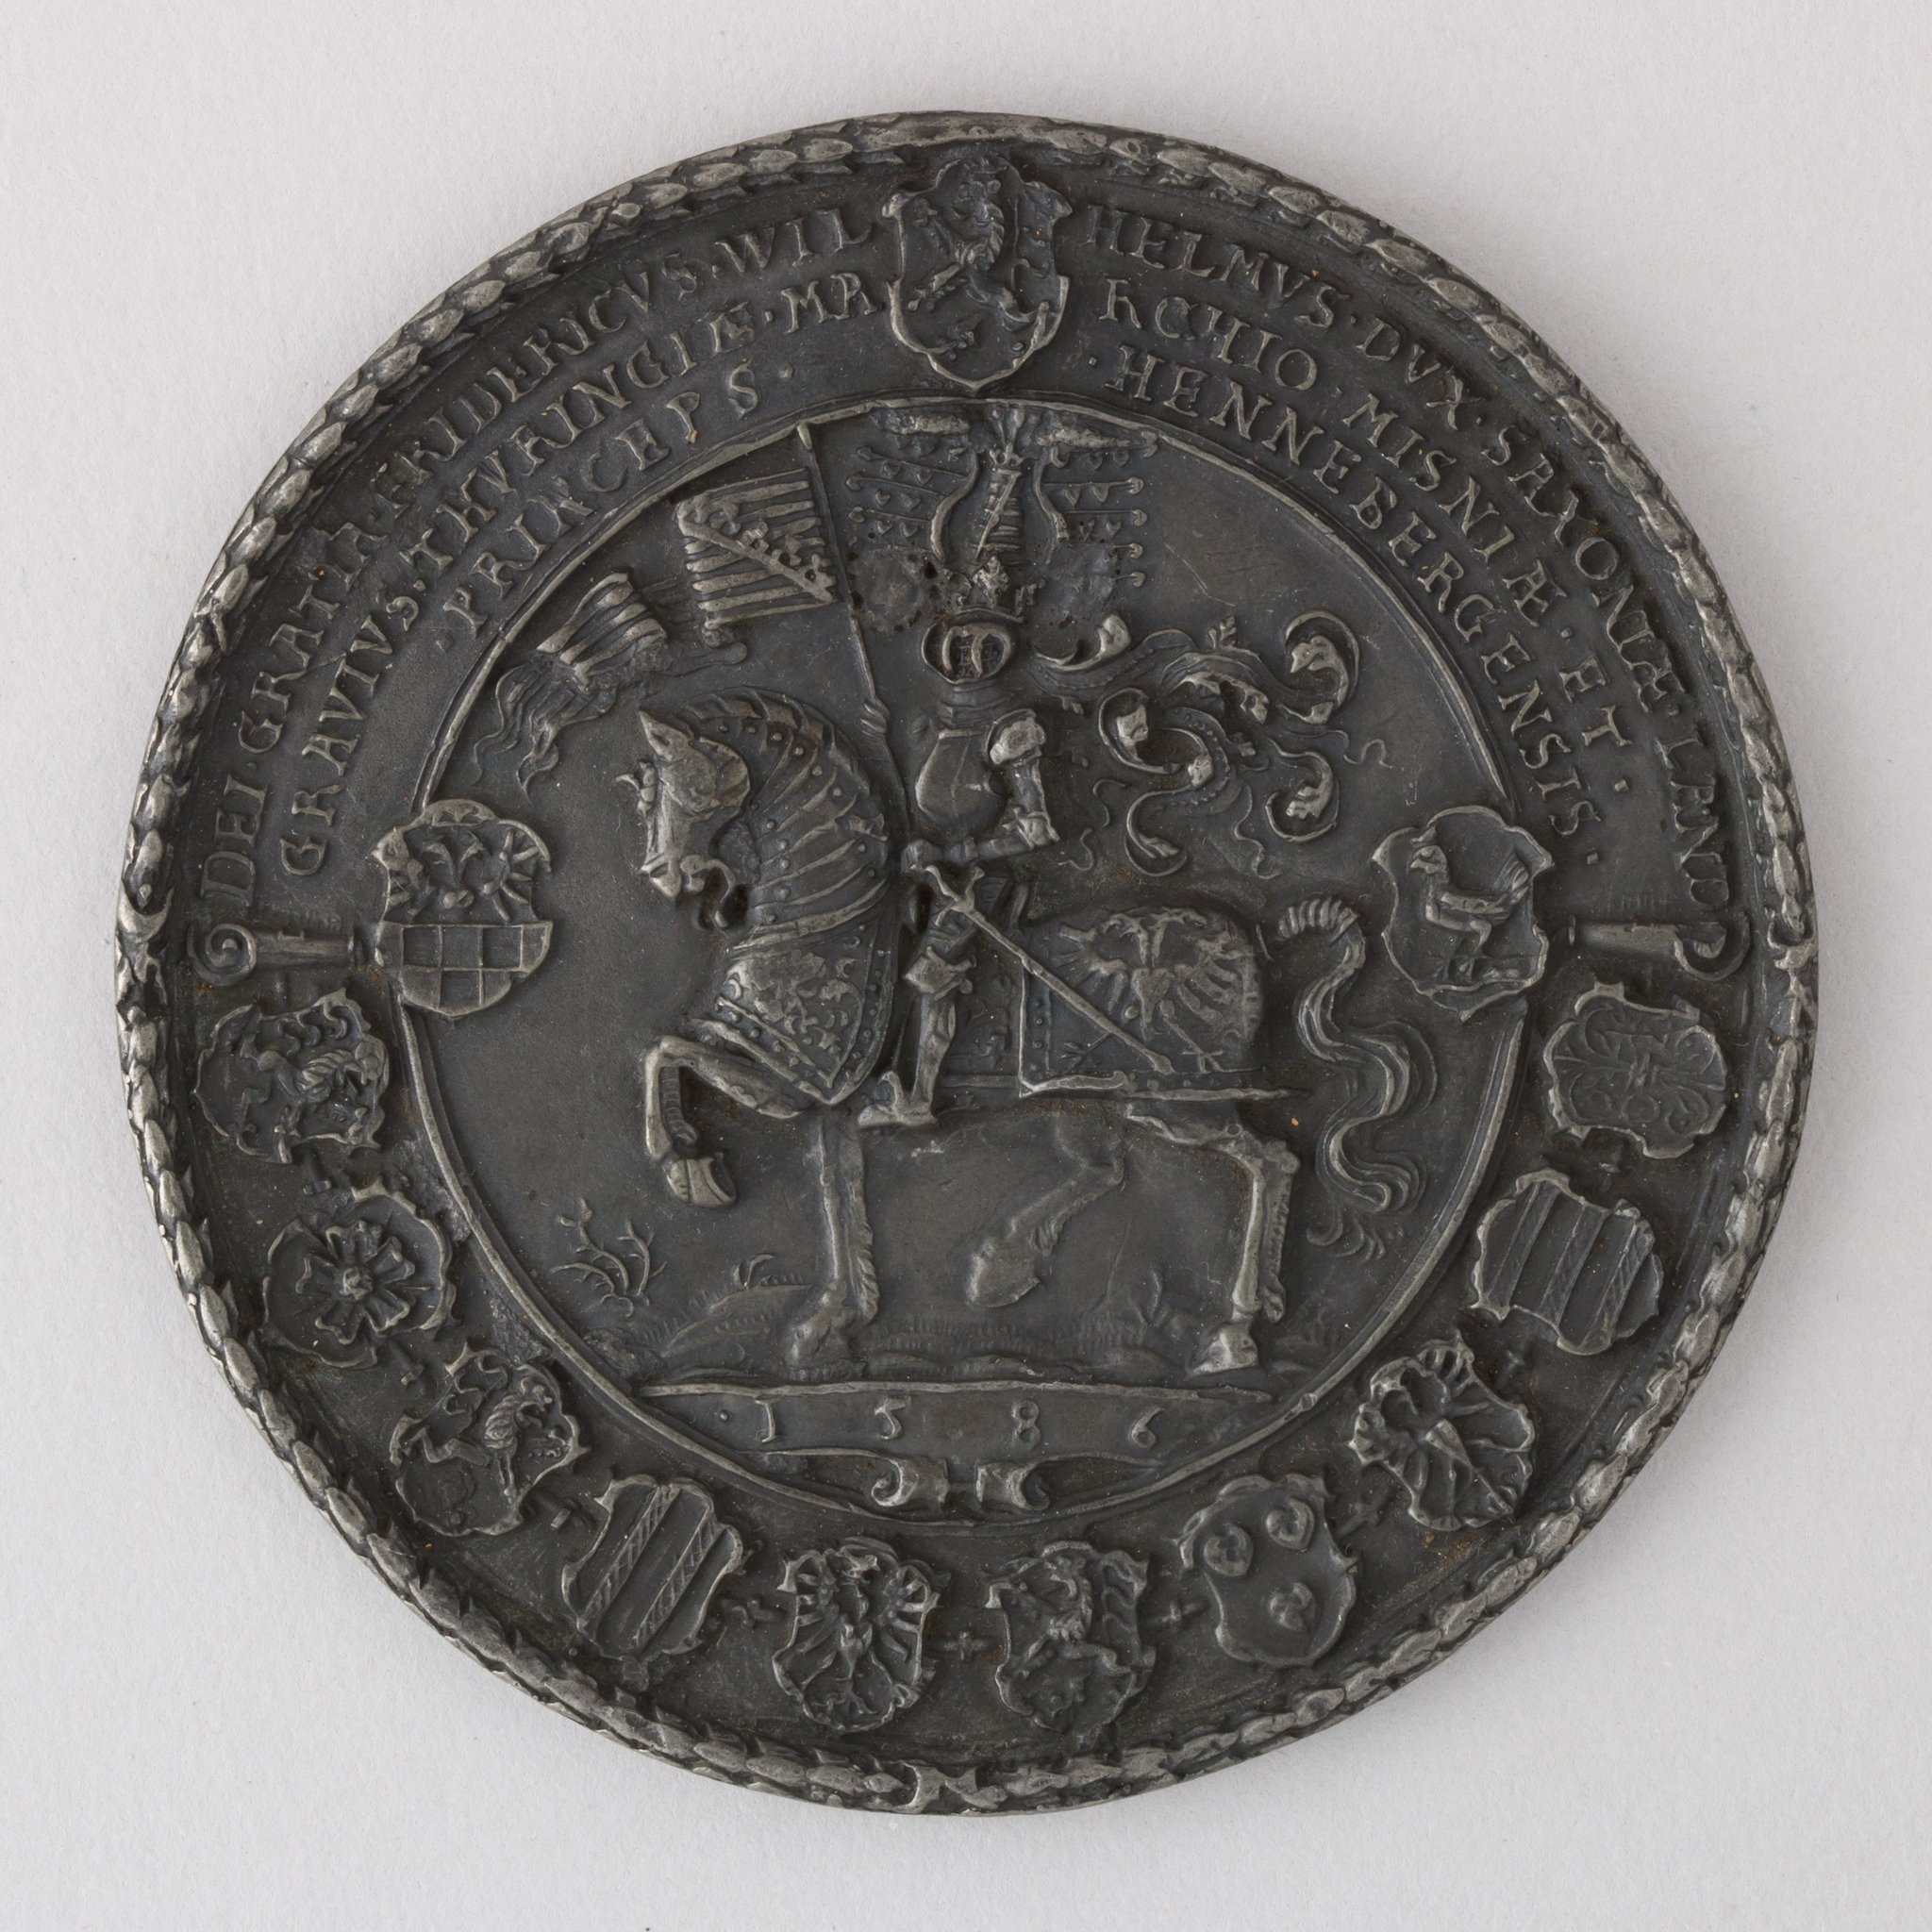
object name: seal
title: Seal of Frederick William, Duke of Saxony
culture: german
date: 1586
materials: lead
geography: germany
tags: men,horses